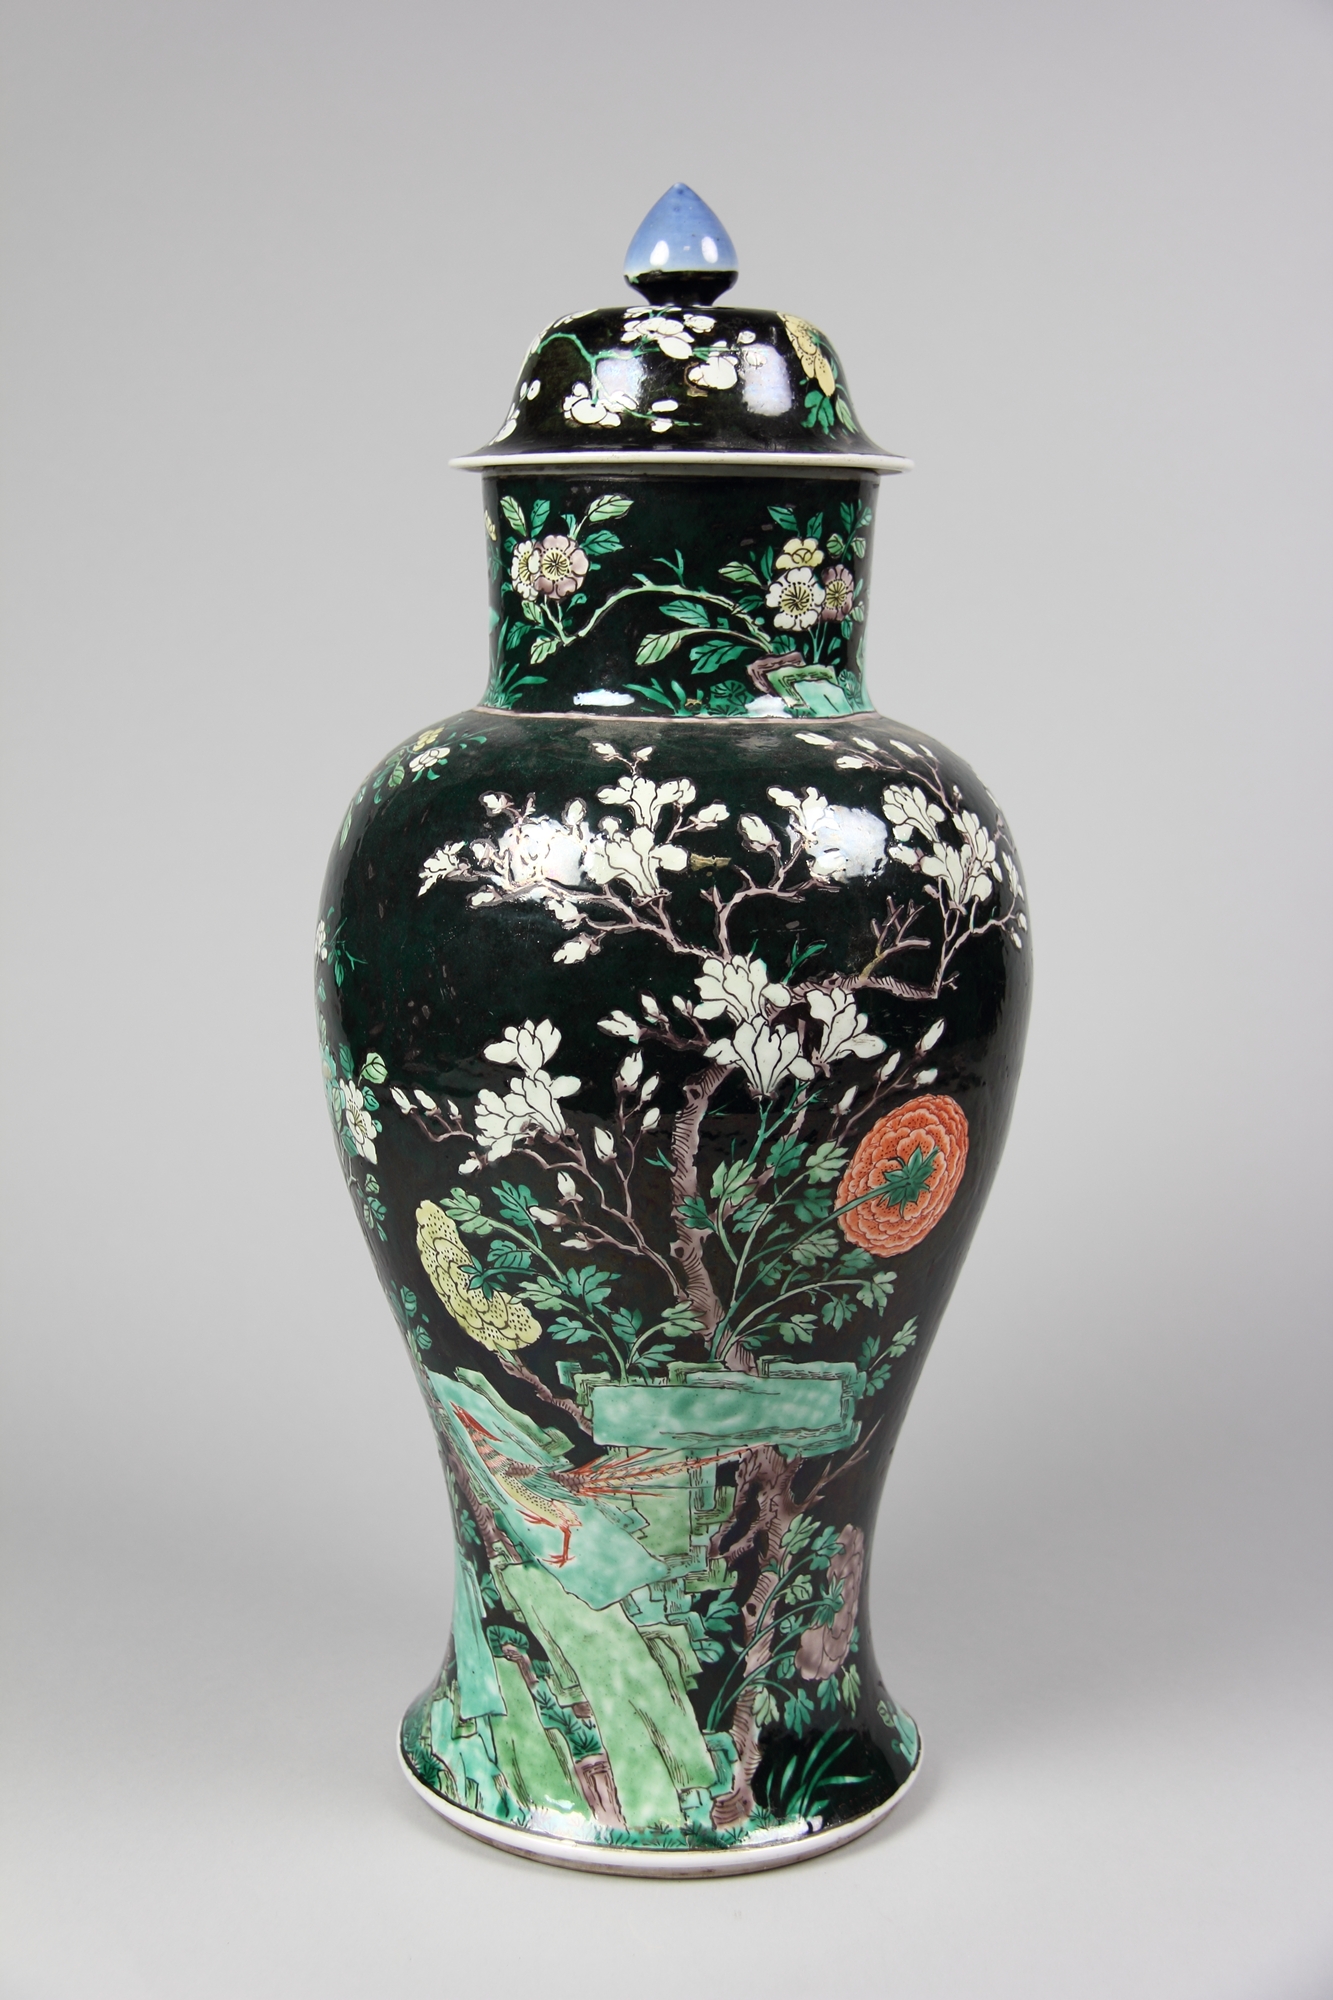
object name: covered jar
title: Covered jar with birds and flowers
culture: chinese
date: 1801-1900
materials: enamel, porcelain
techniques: painting, polychrome